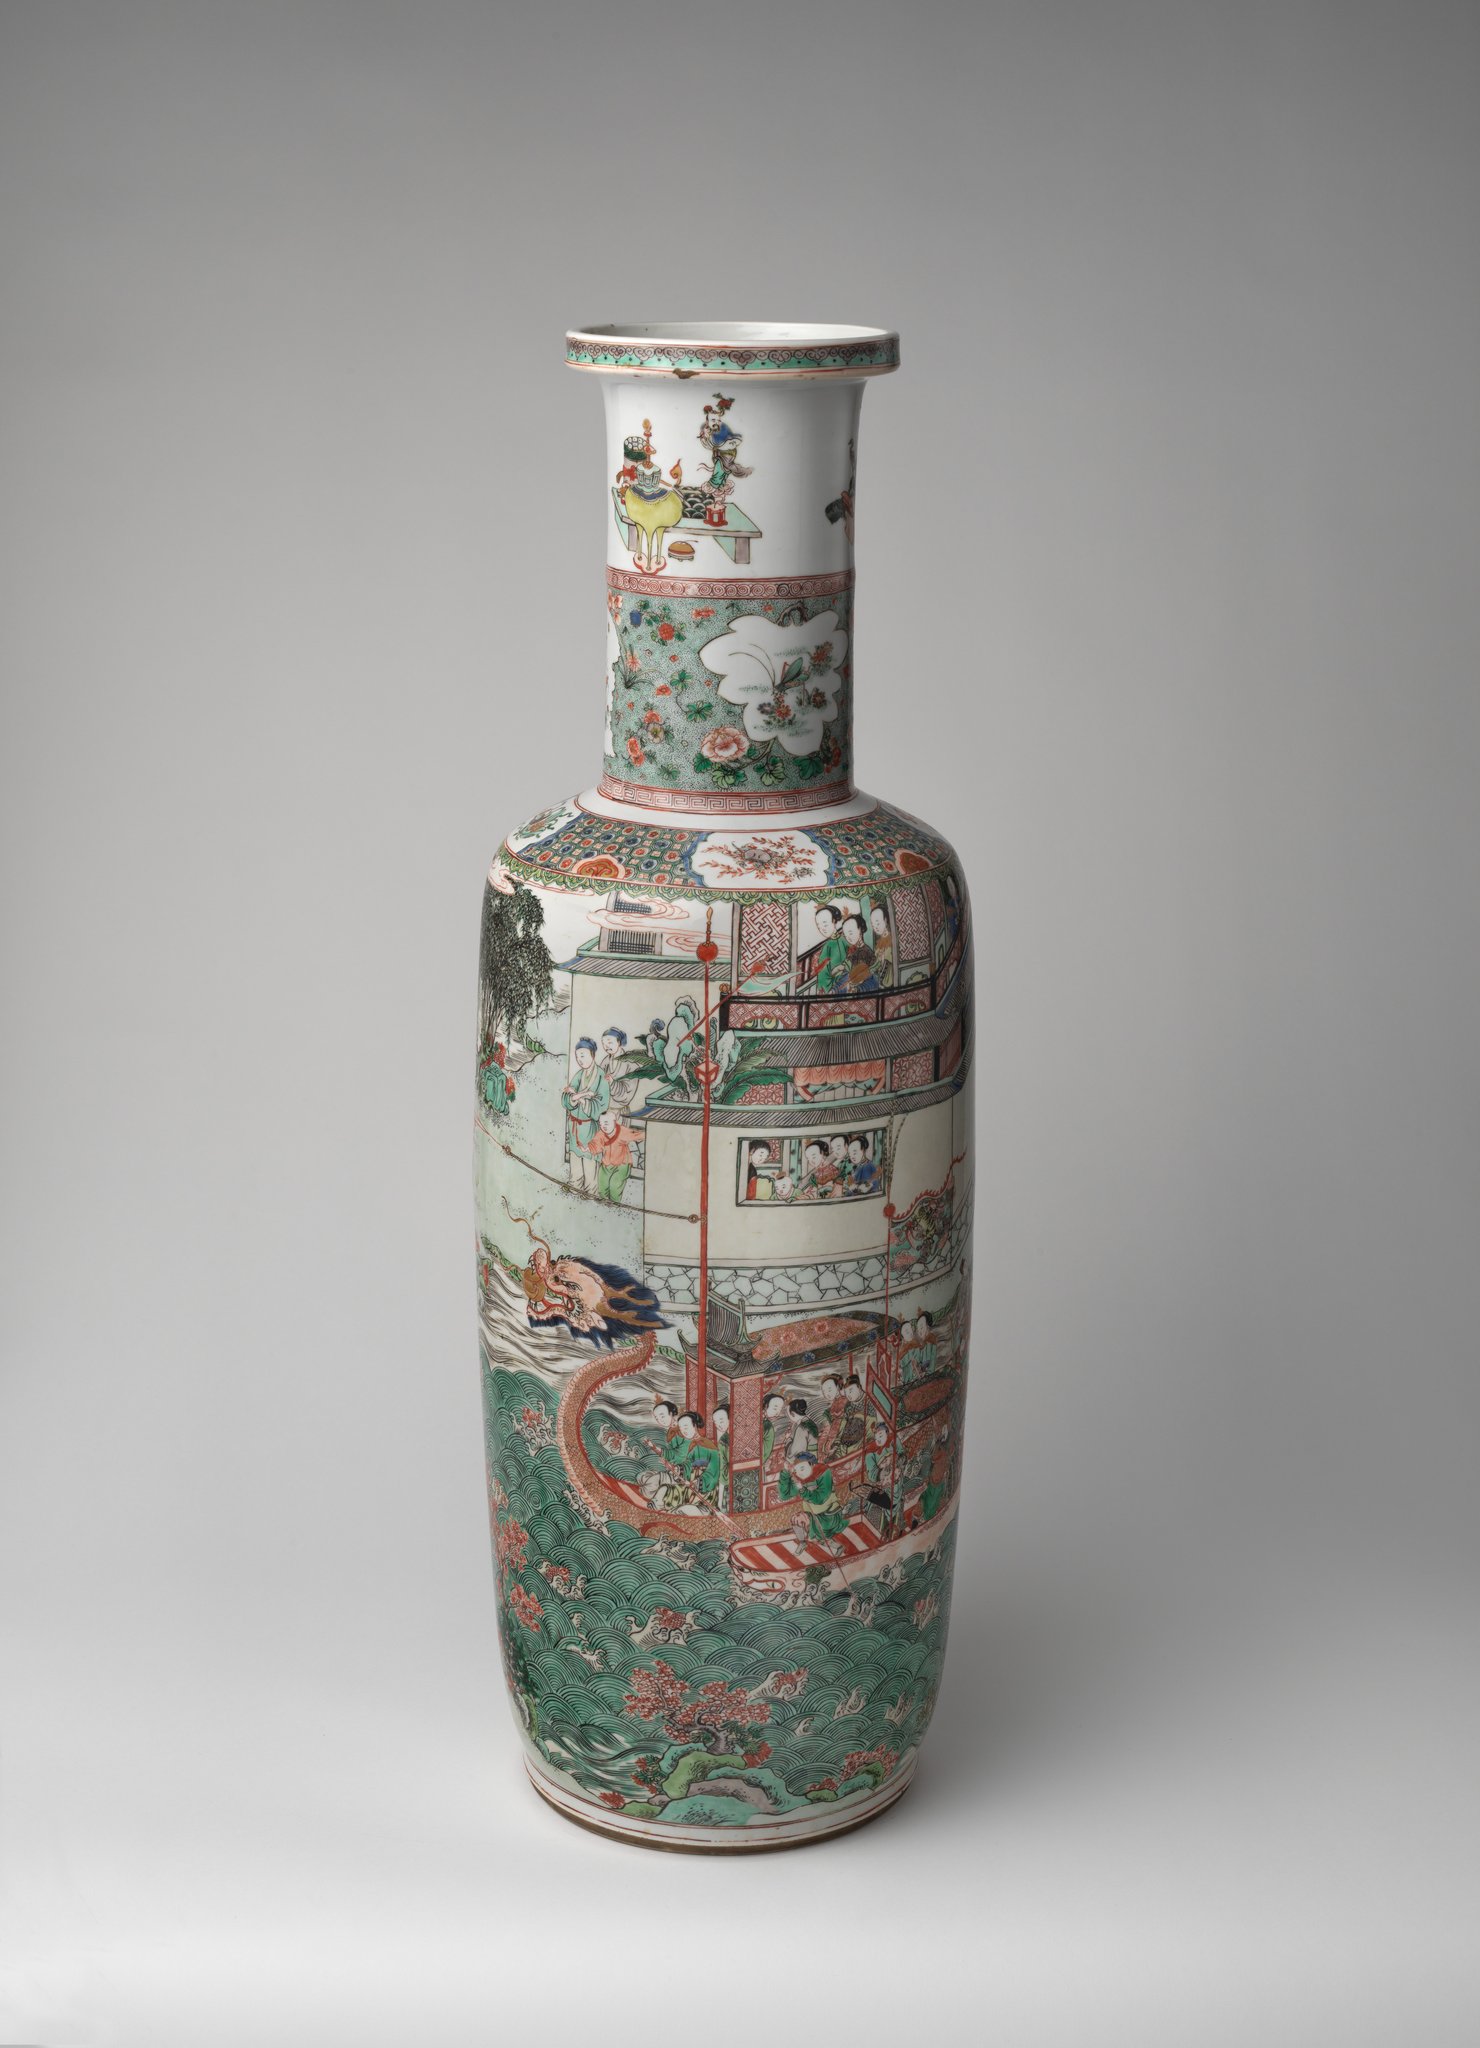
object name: vase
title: Vase with performance of dragon boat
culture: chinese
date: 1667-1733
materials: enamel, porcelain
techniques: overglaze, painting, polychrome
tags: human figures,dragons,flowers,trees